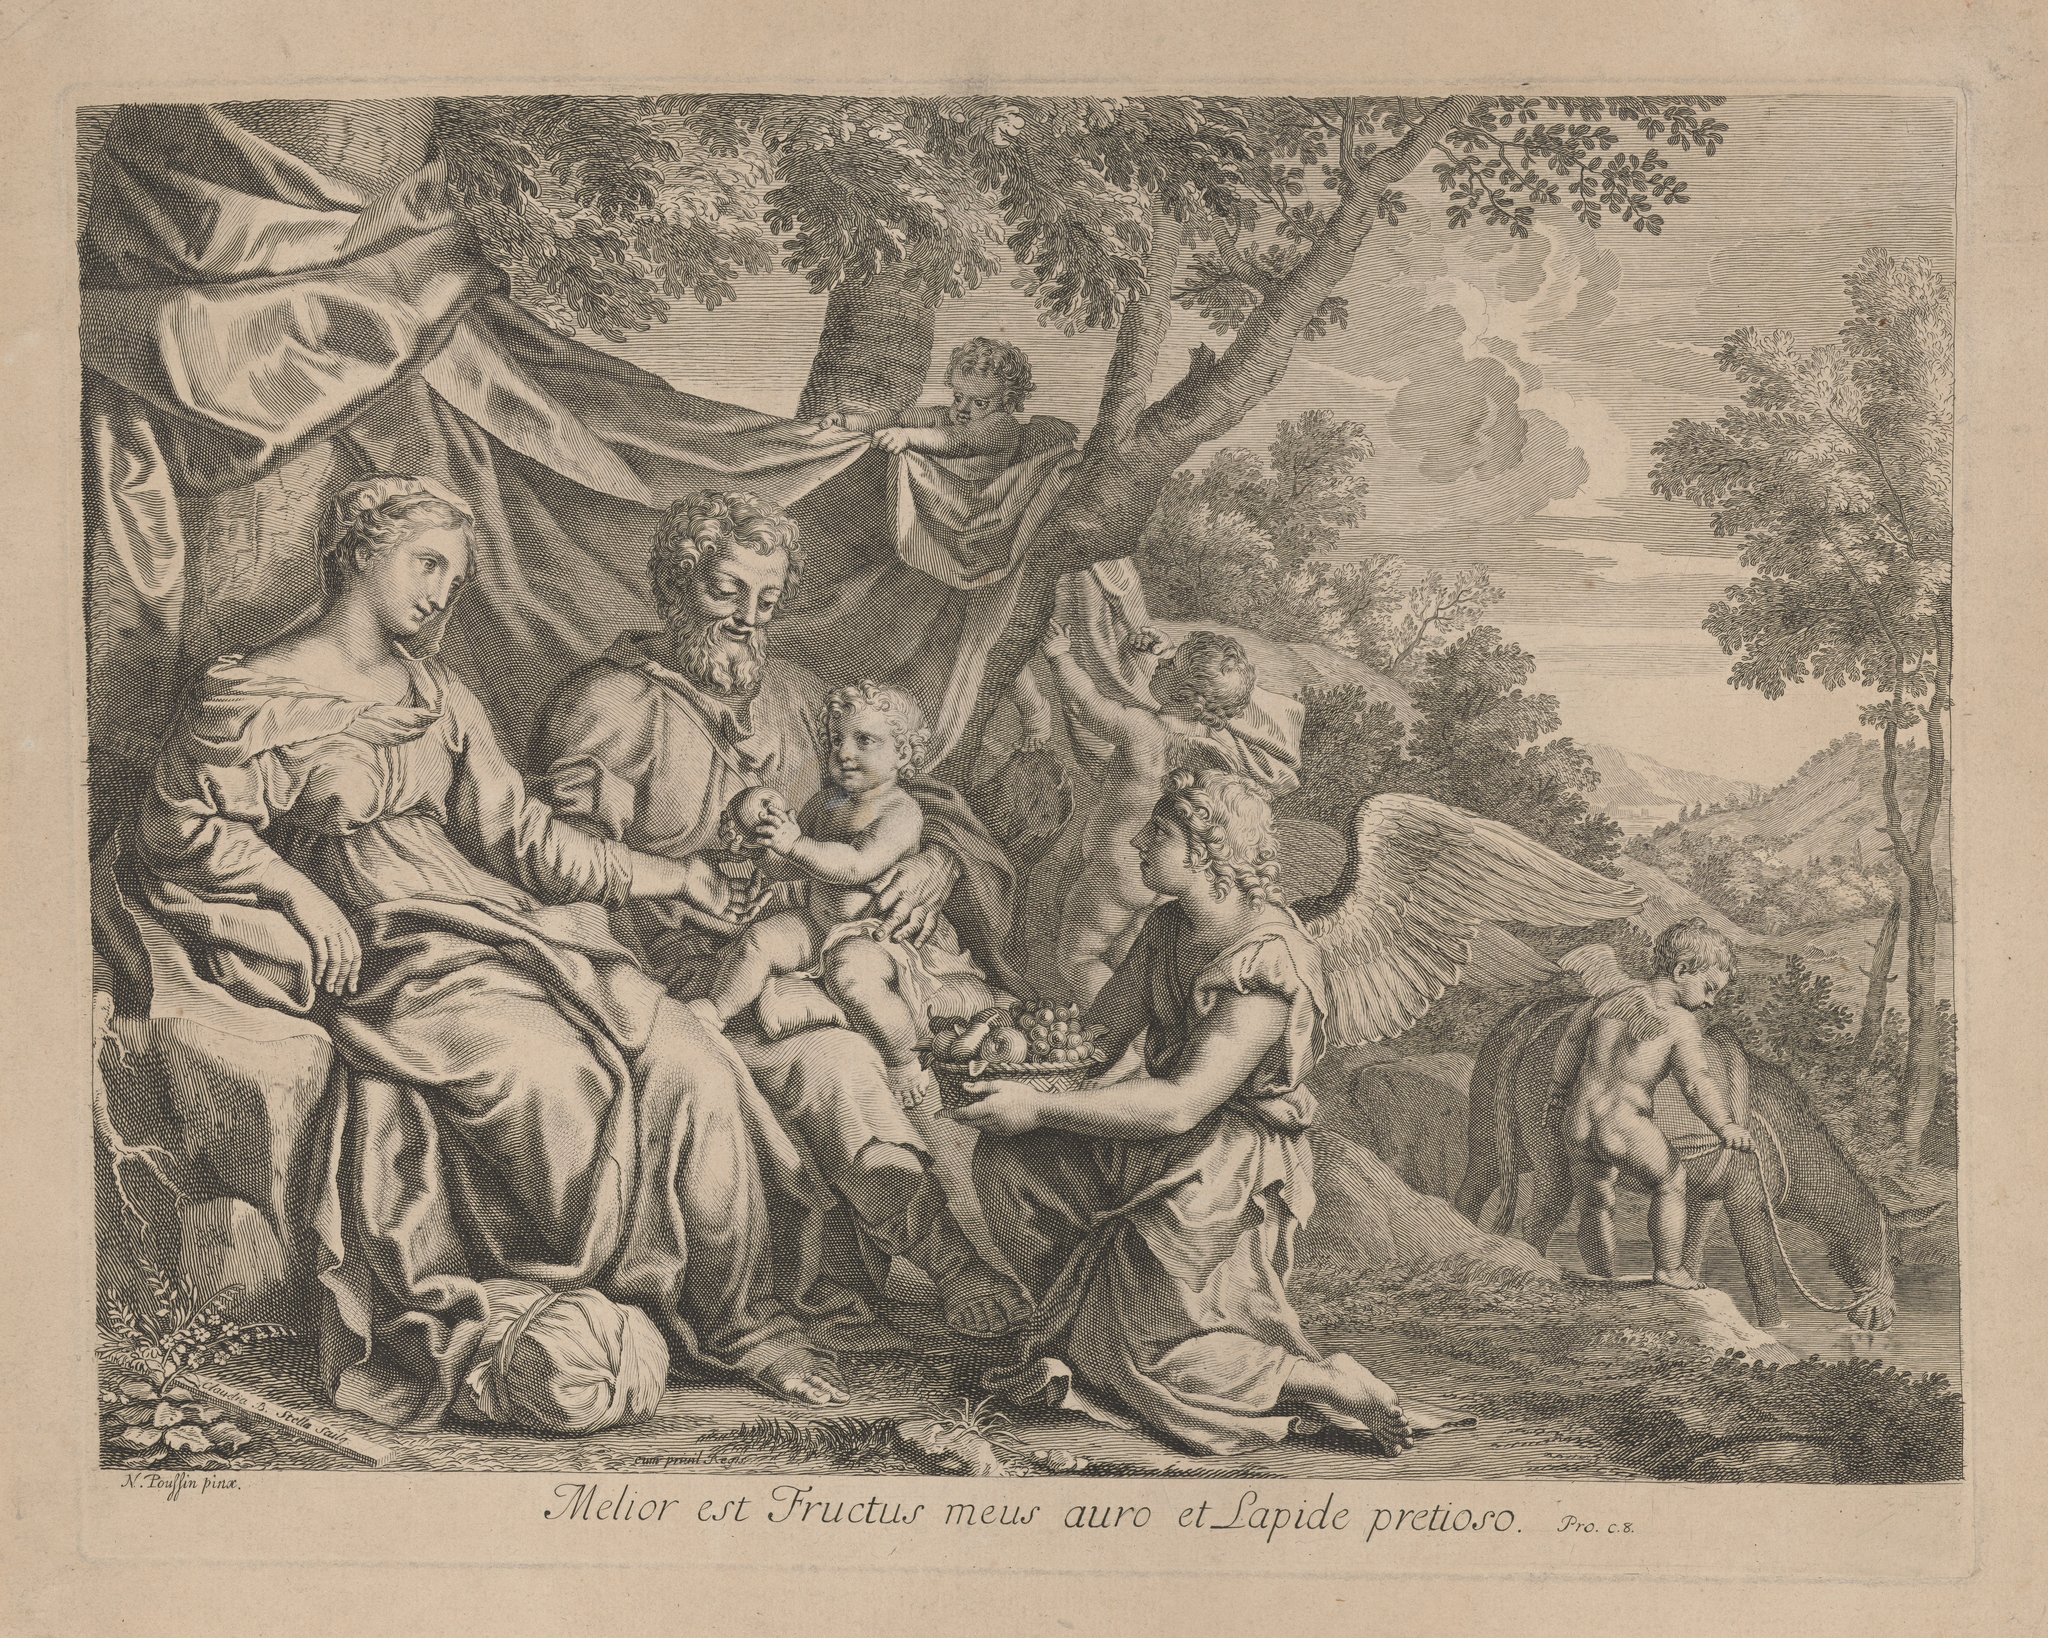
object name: print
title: Melior est Fructus meus auro et Lapide pretiso. Pro. C. 8. (My fruit is better than gold and precious stones)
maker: claudine bouzonnet stella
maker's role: artist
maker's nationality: french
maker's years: 1636-1697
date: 1660-1669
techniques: engraving, etching